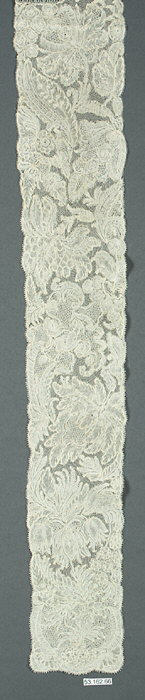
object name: lappet and cap edging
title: Pair of lappets and joined cap edging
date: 1701-1733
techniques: lace